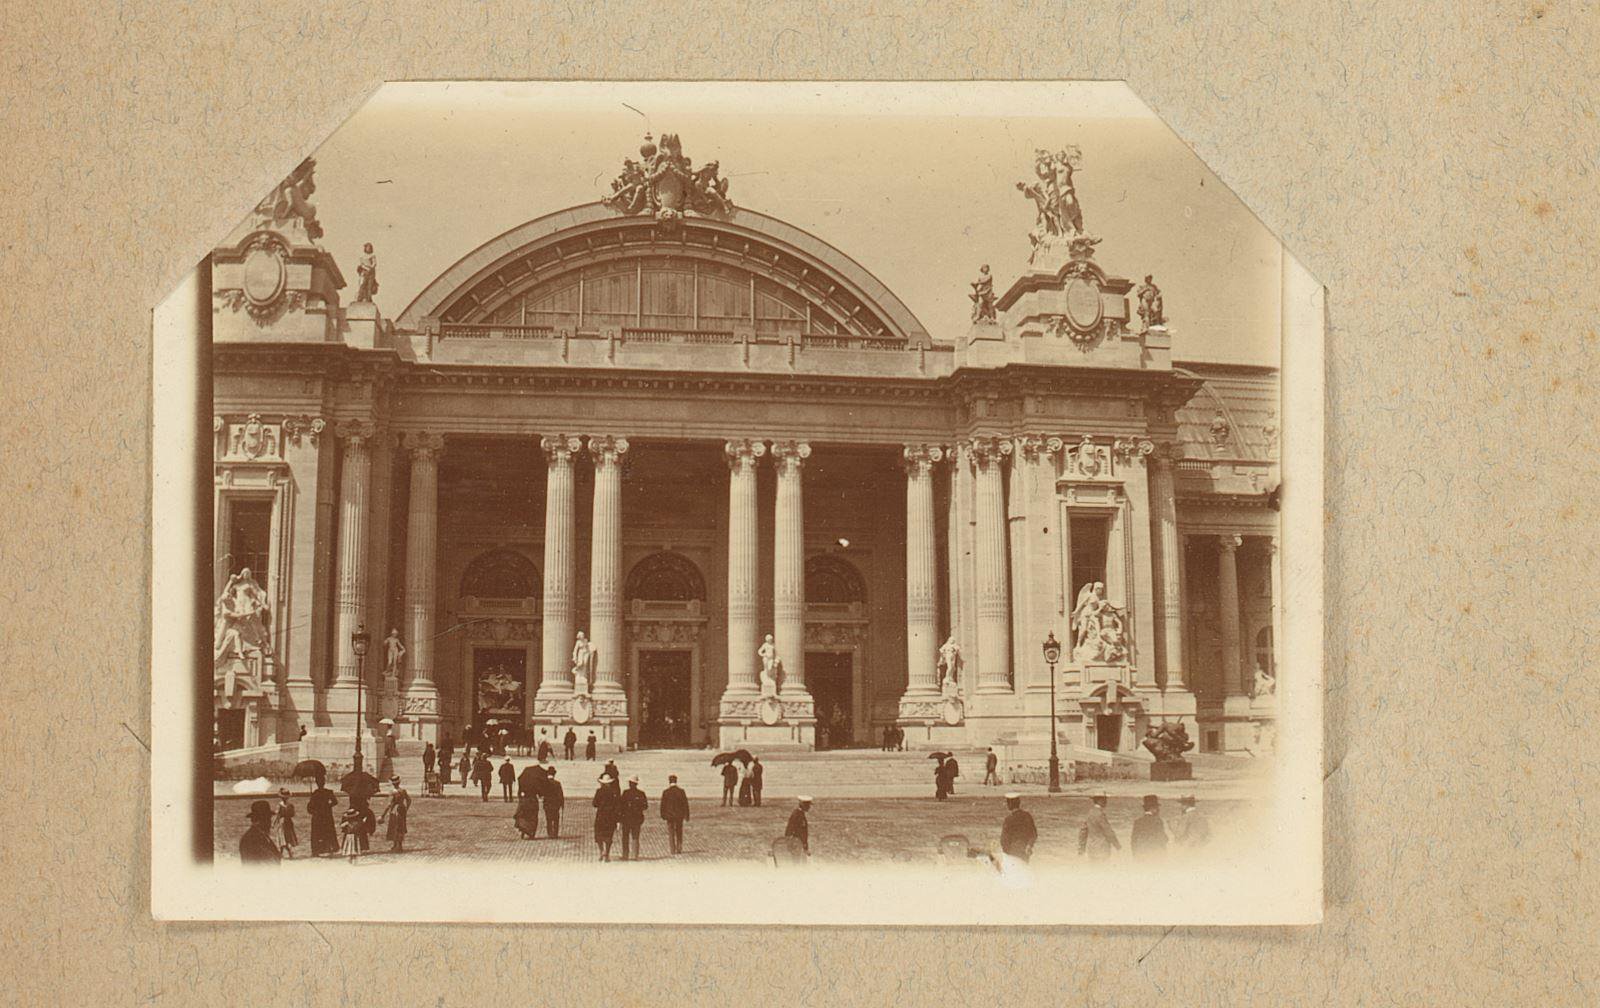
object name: album leaf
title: Entree van het Grand Palais tijdens de Wereldtentoonstelling van 1900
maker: Anonymous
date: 1900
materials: paper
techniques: gelatin silver print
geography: paris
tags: world fair, world exhibition, paris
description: Over de foto is een ander negatief afgedrukt van een voorstelling van bomen.